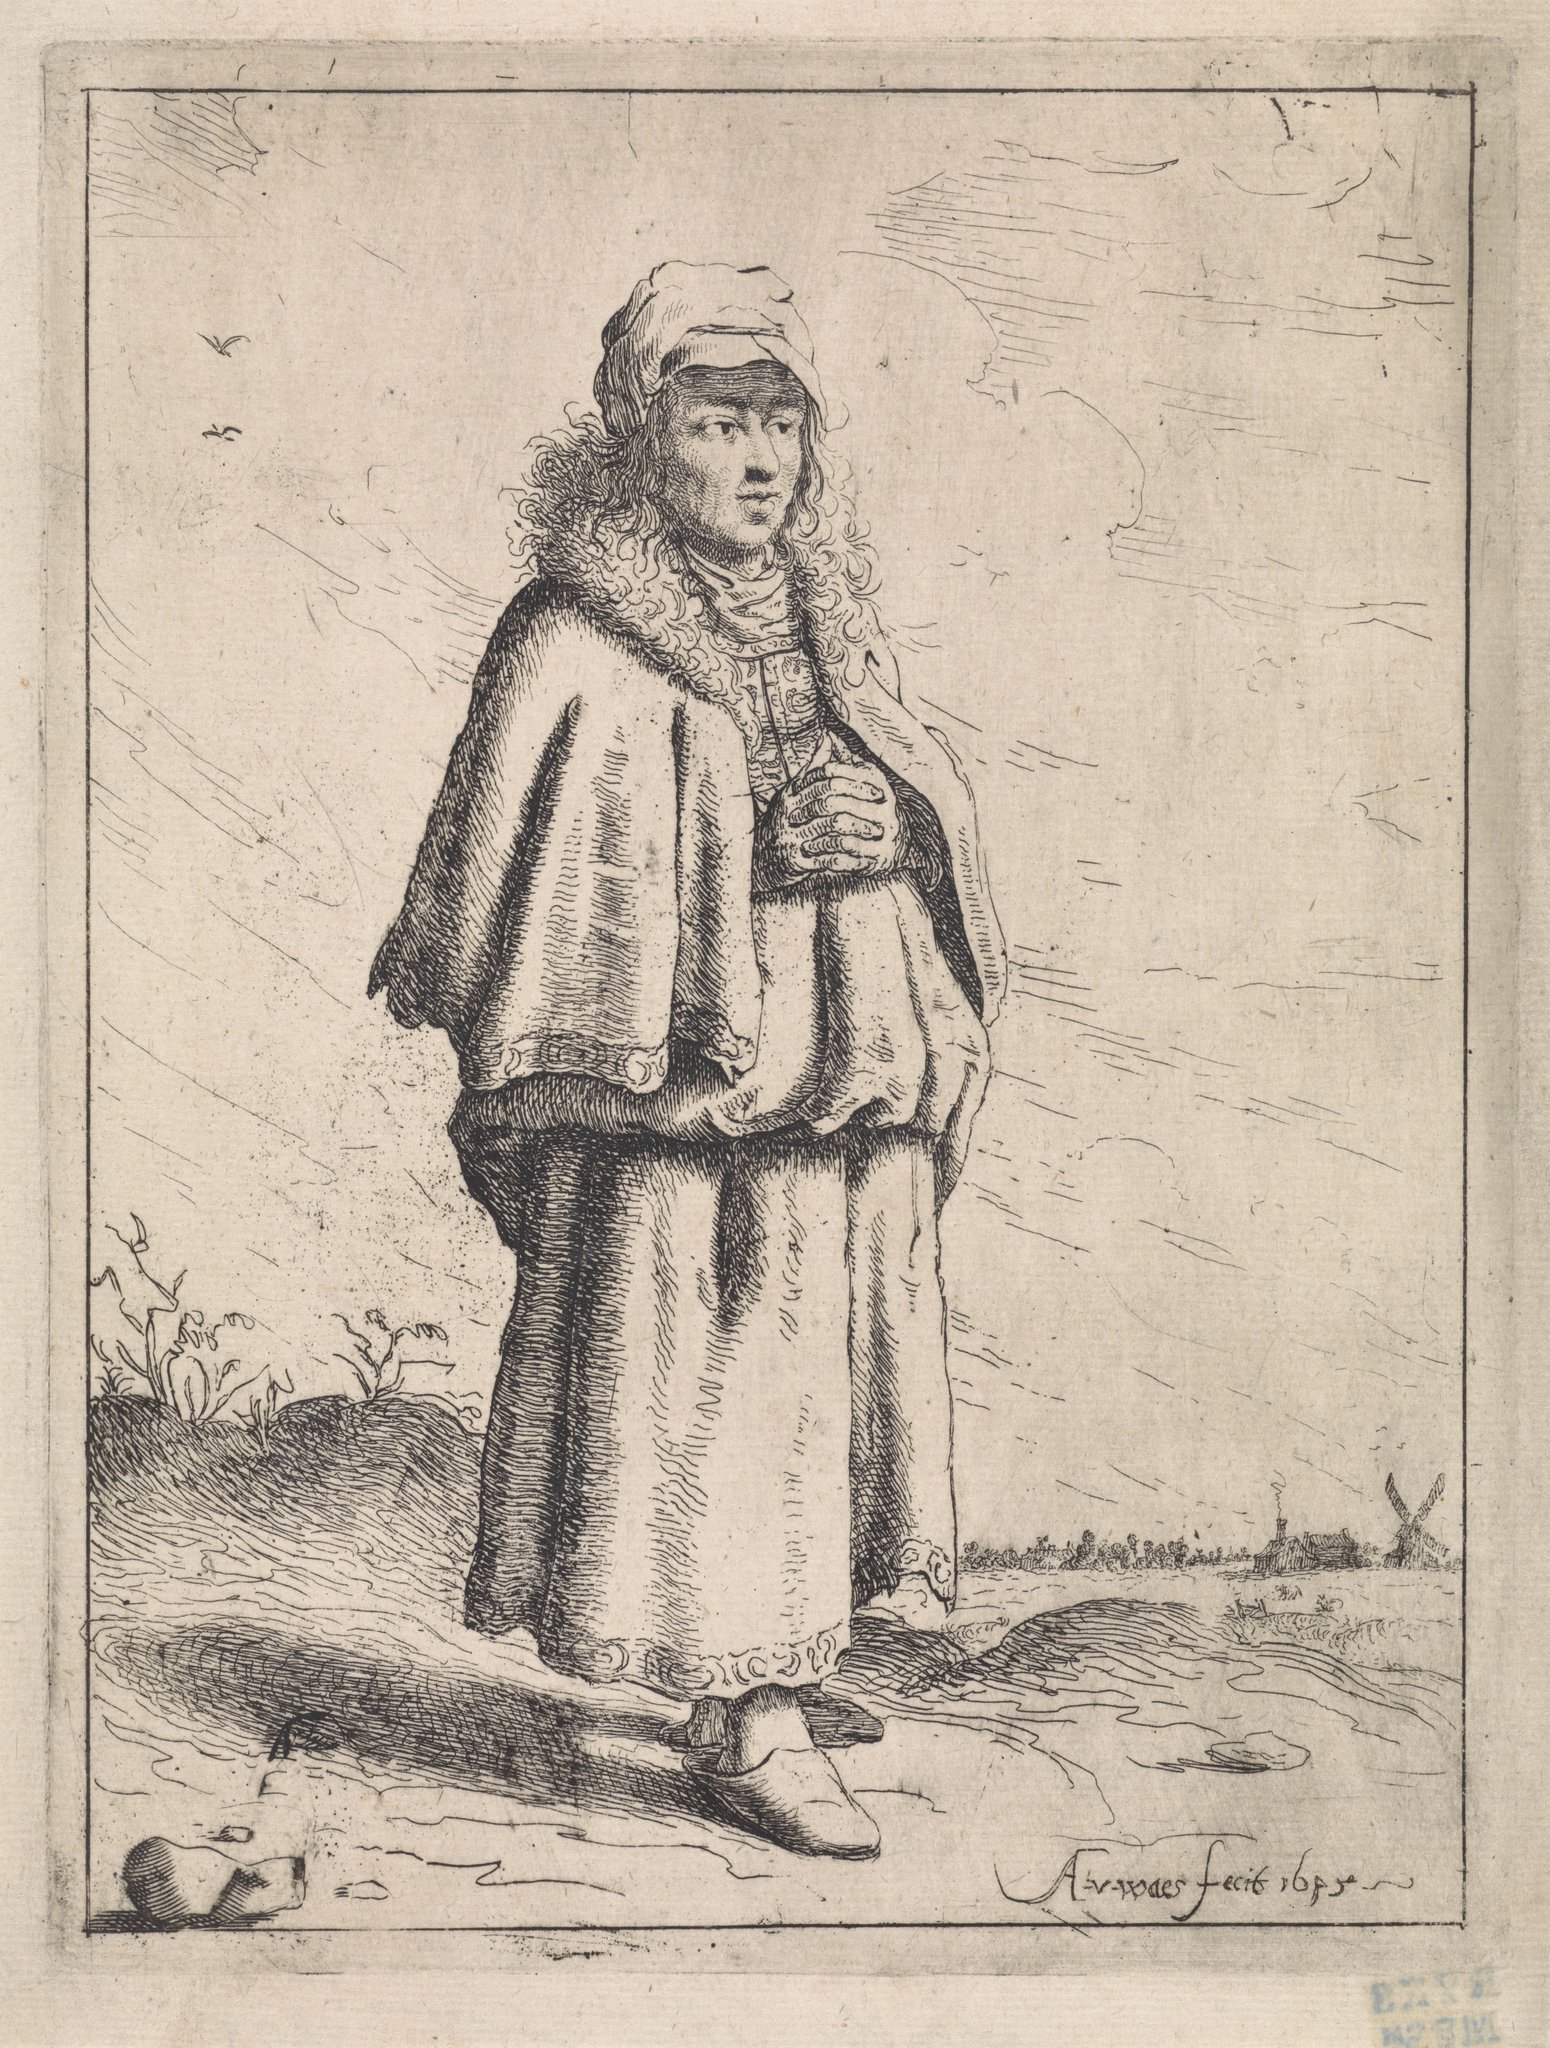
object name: print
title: Vrouw met gevouwen handen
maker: aert van waes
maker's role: draughtsman, print maker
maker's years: 1620-1664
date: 1645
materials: paper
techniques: etching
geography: gouda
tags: windmill in landscape, hands folded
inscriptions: collector's mark: Lugt 2165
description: Een vrouw staat met haar handen gevouwen voor zich in een landschap.